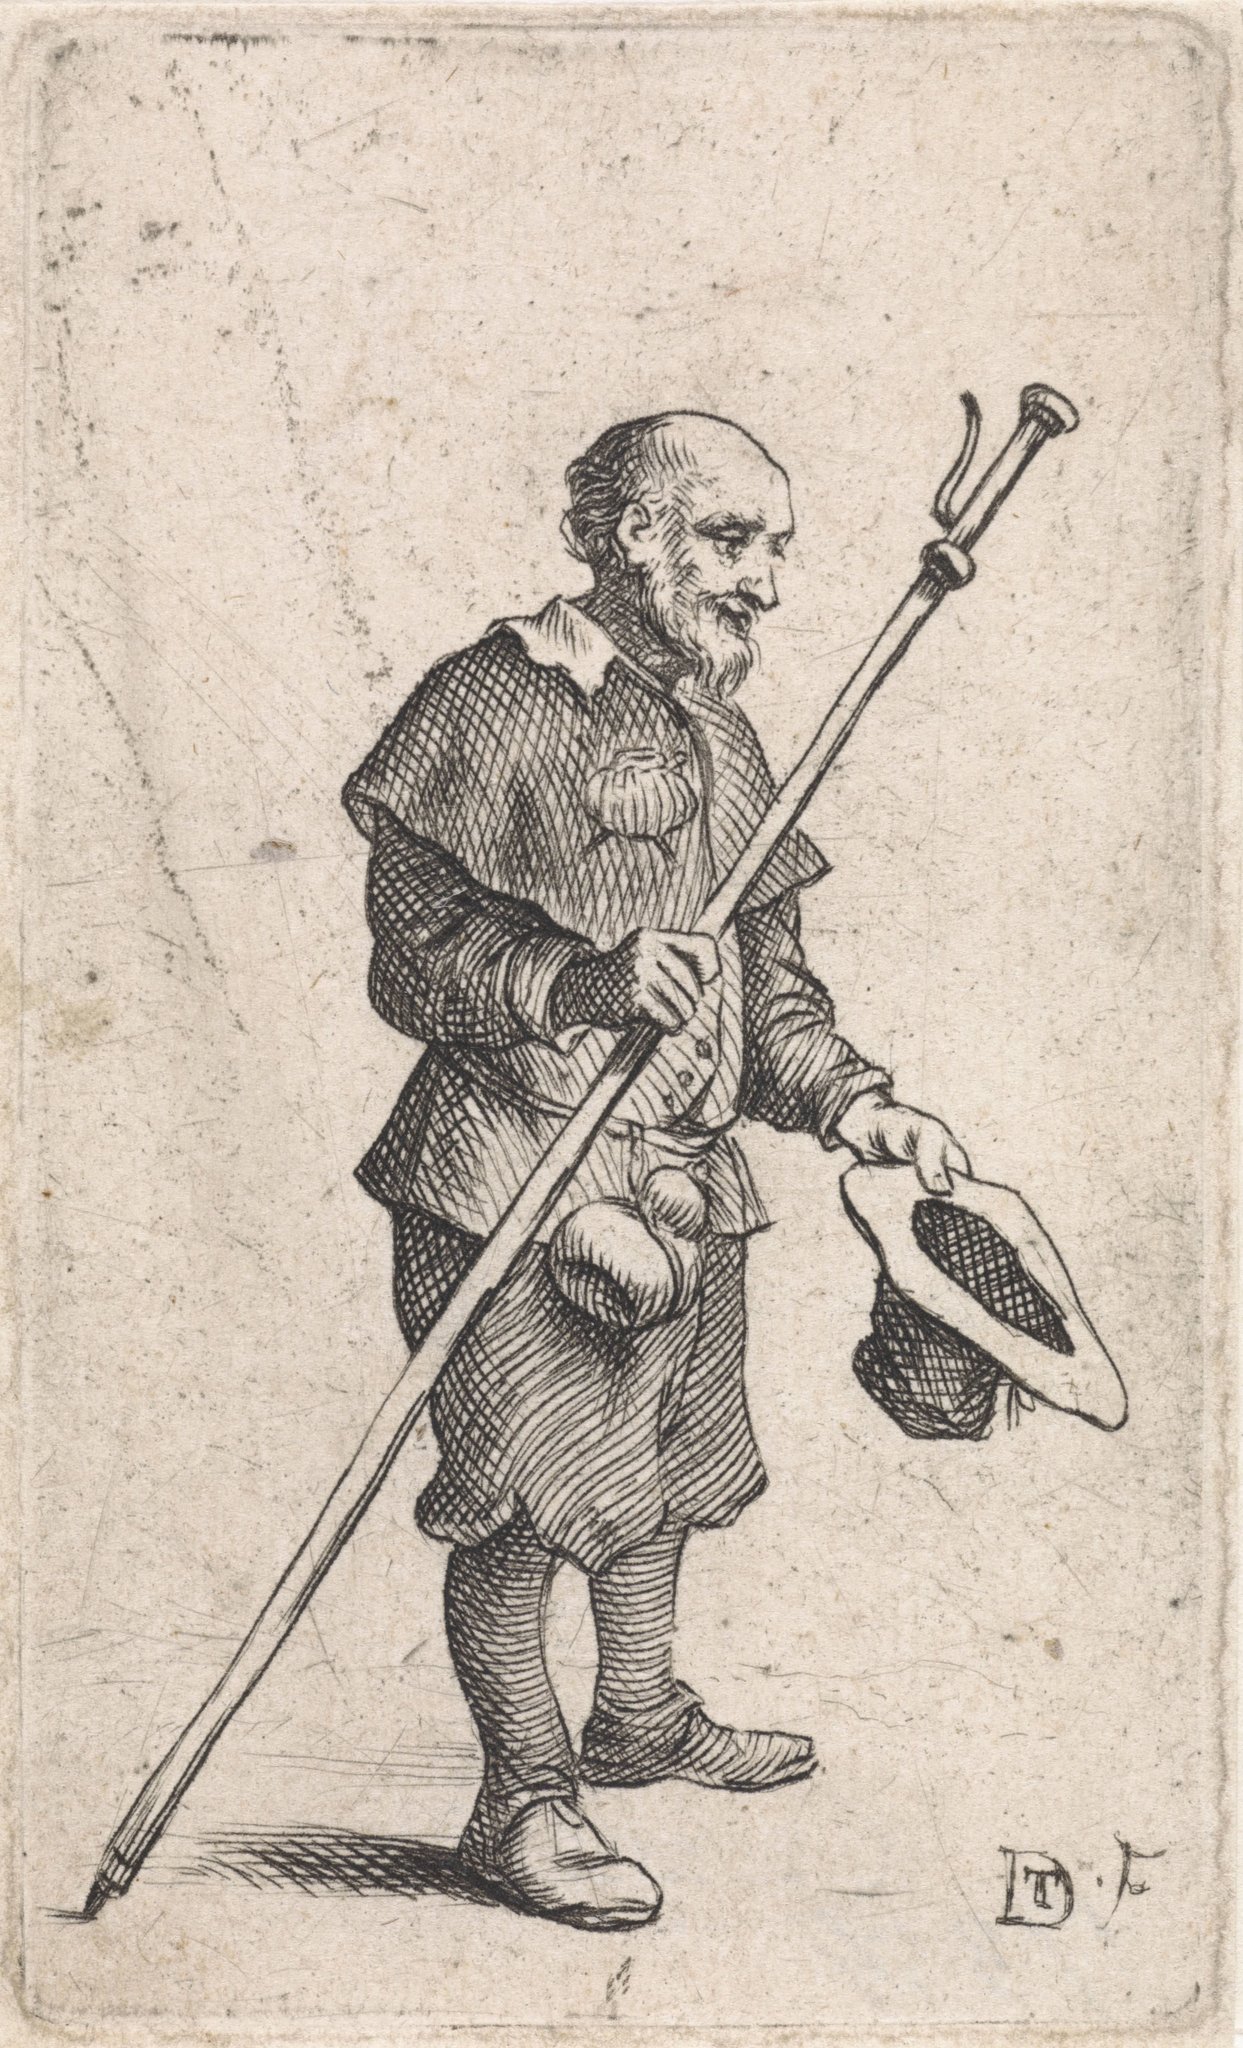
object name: print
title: Pelgrim met staf en hoed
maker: david teniers (ii)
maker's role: draughtsman, painter, print maker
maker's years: 1610-1690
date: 1626-1690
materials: paper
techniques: etching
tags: pilgrim(s)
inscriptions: collector's mark: Lugt 2228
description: Een pelgrim met een hoed in de linker- en een staf in de rechterhand. Op zijn mantel een Jacobsschelp.